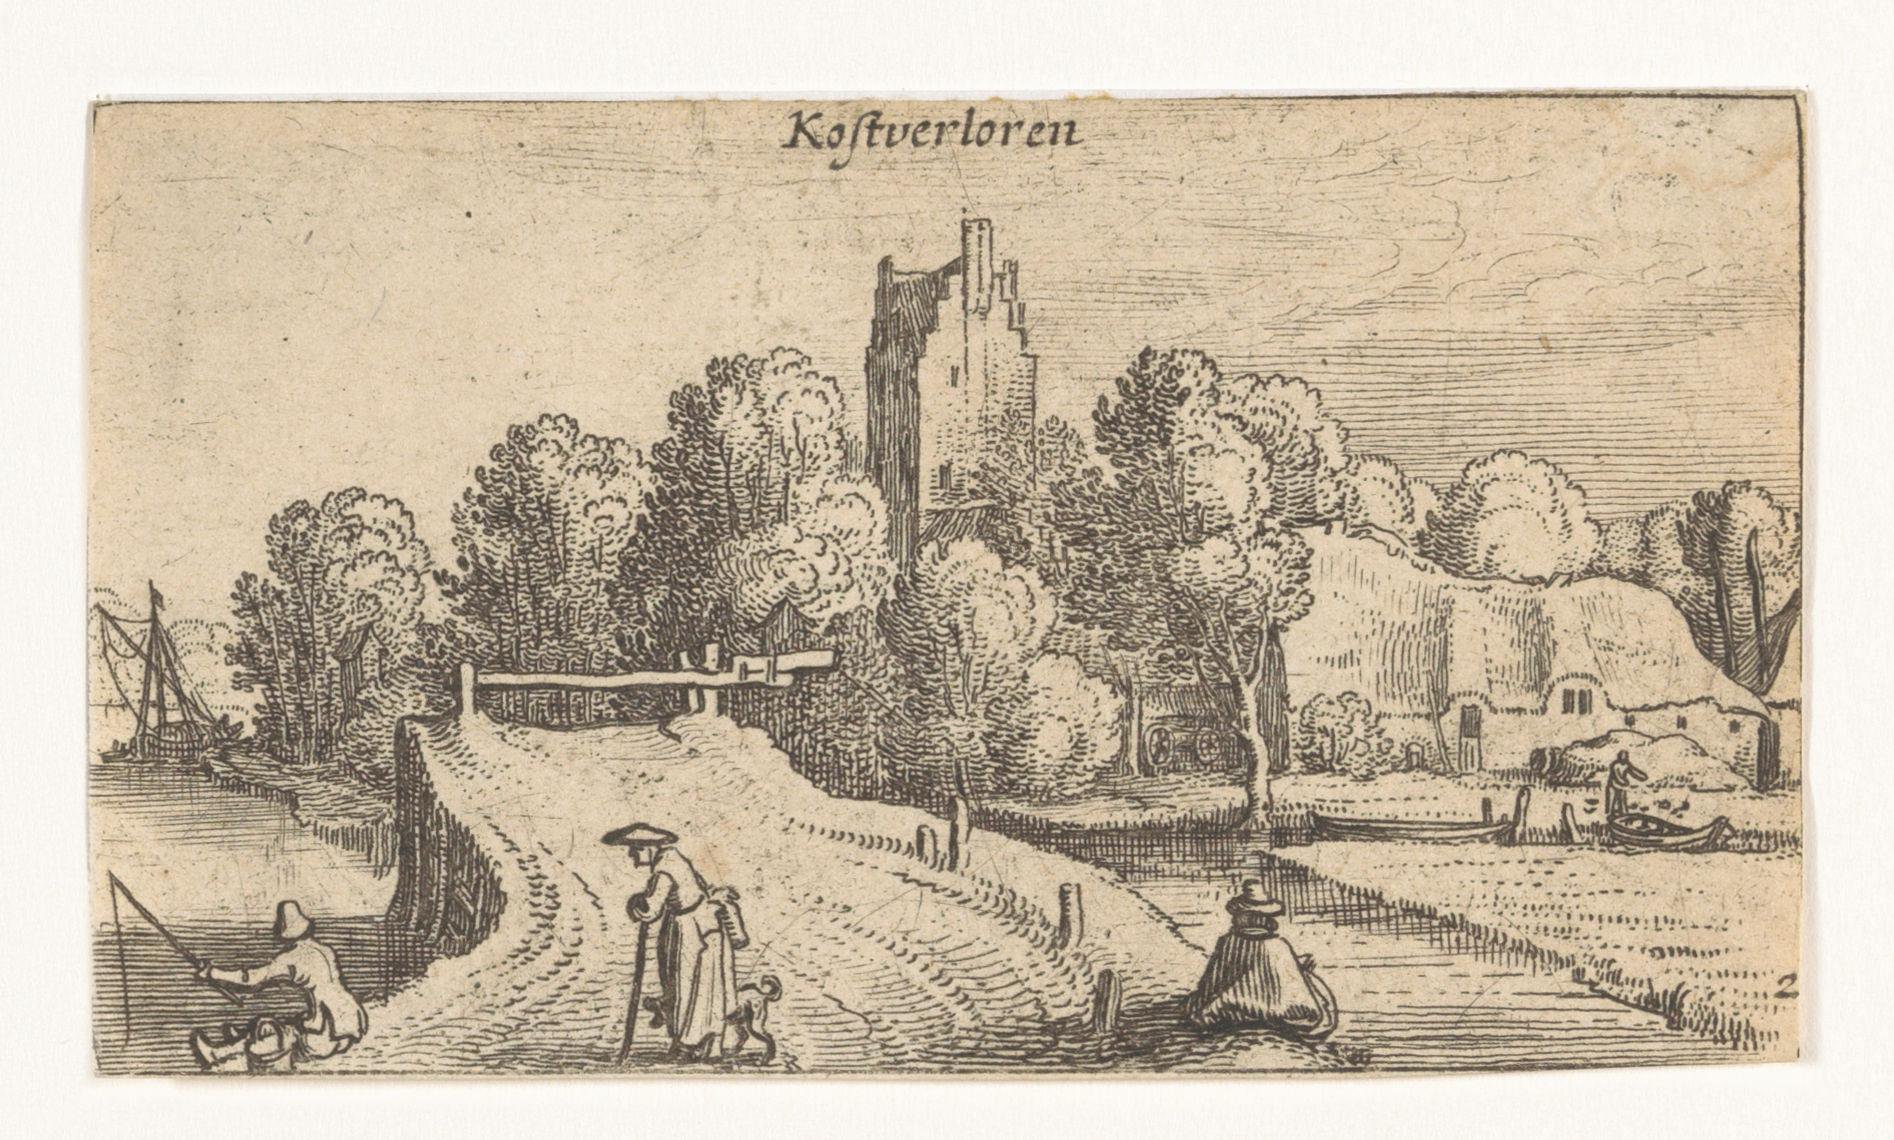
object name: print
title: Kostverloren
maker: claes jansz. visscher (ii)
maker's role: draughtsman, print maker, publisher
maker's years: 1586-1652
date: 1601-1652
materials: paper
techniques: etching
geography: amsterdam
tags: landscapes, villa, fisherman, dog, country-house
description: Gezicht op Huis Kostverloren nabij Amsterdam, waarnaast een lage boerderij. Op de voorgrond een visser en een vrouw, leunend op haar stok, met een hond. Rechts zit een figuur aan de waterkant. Rechtsonder genummerd: 2.